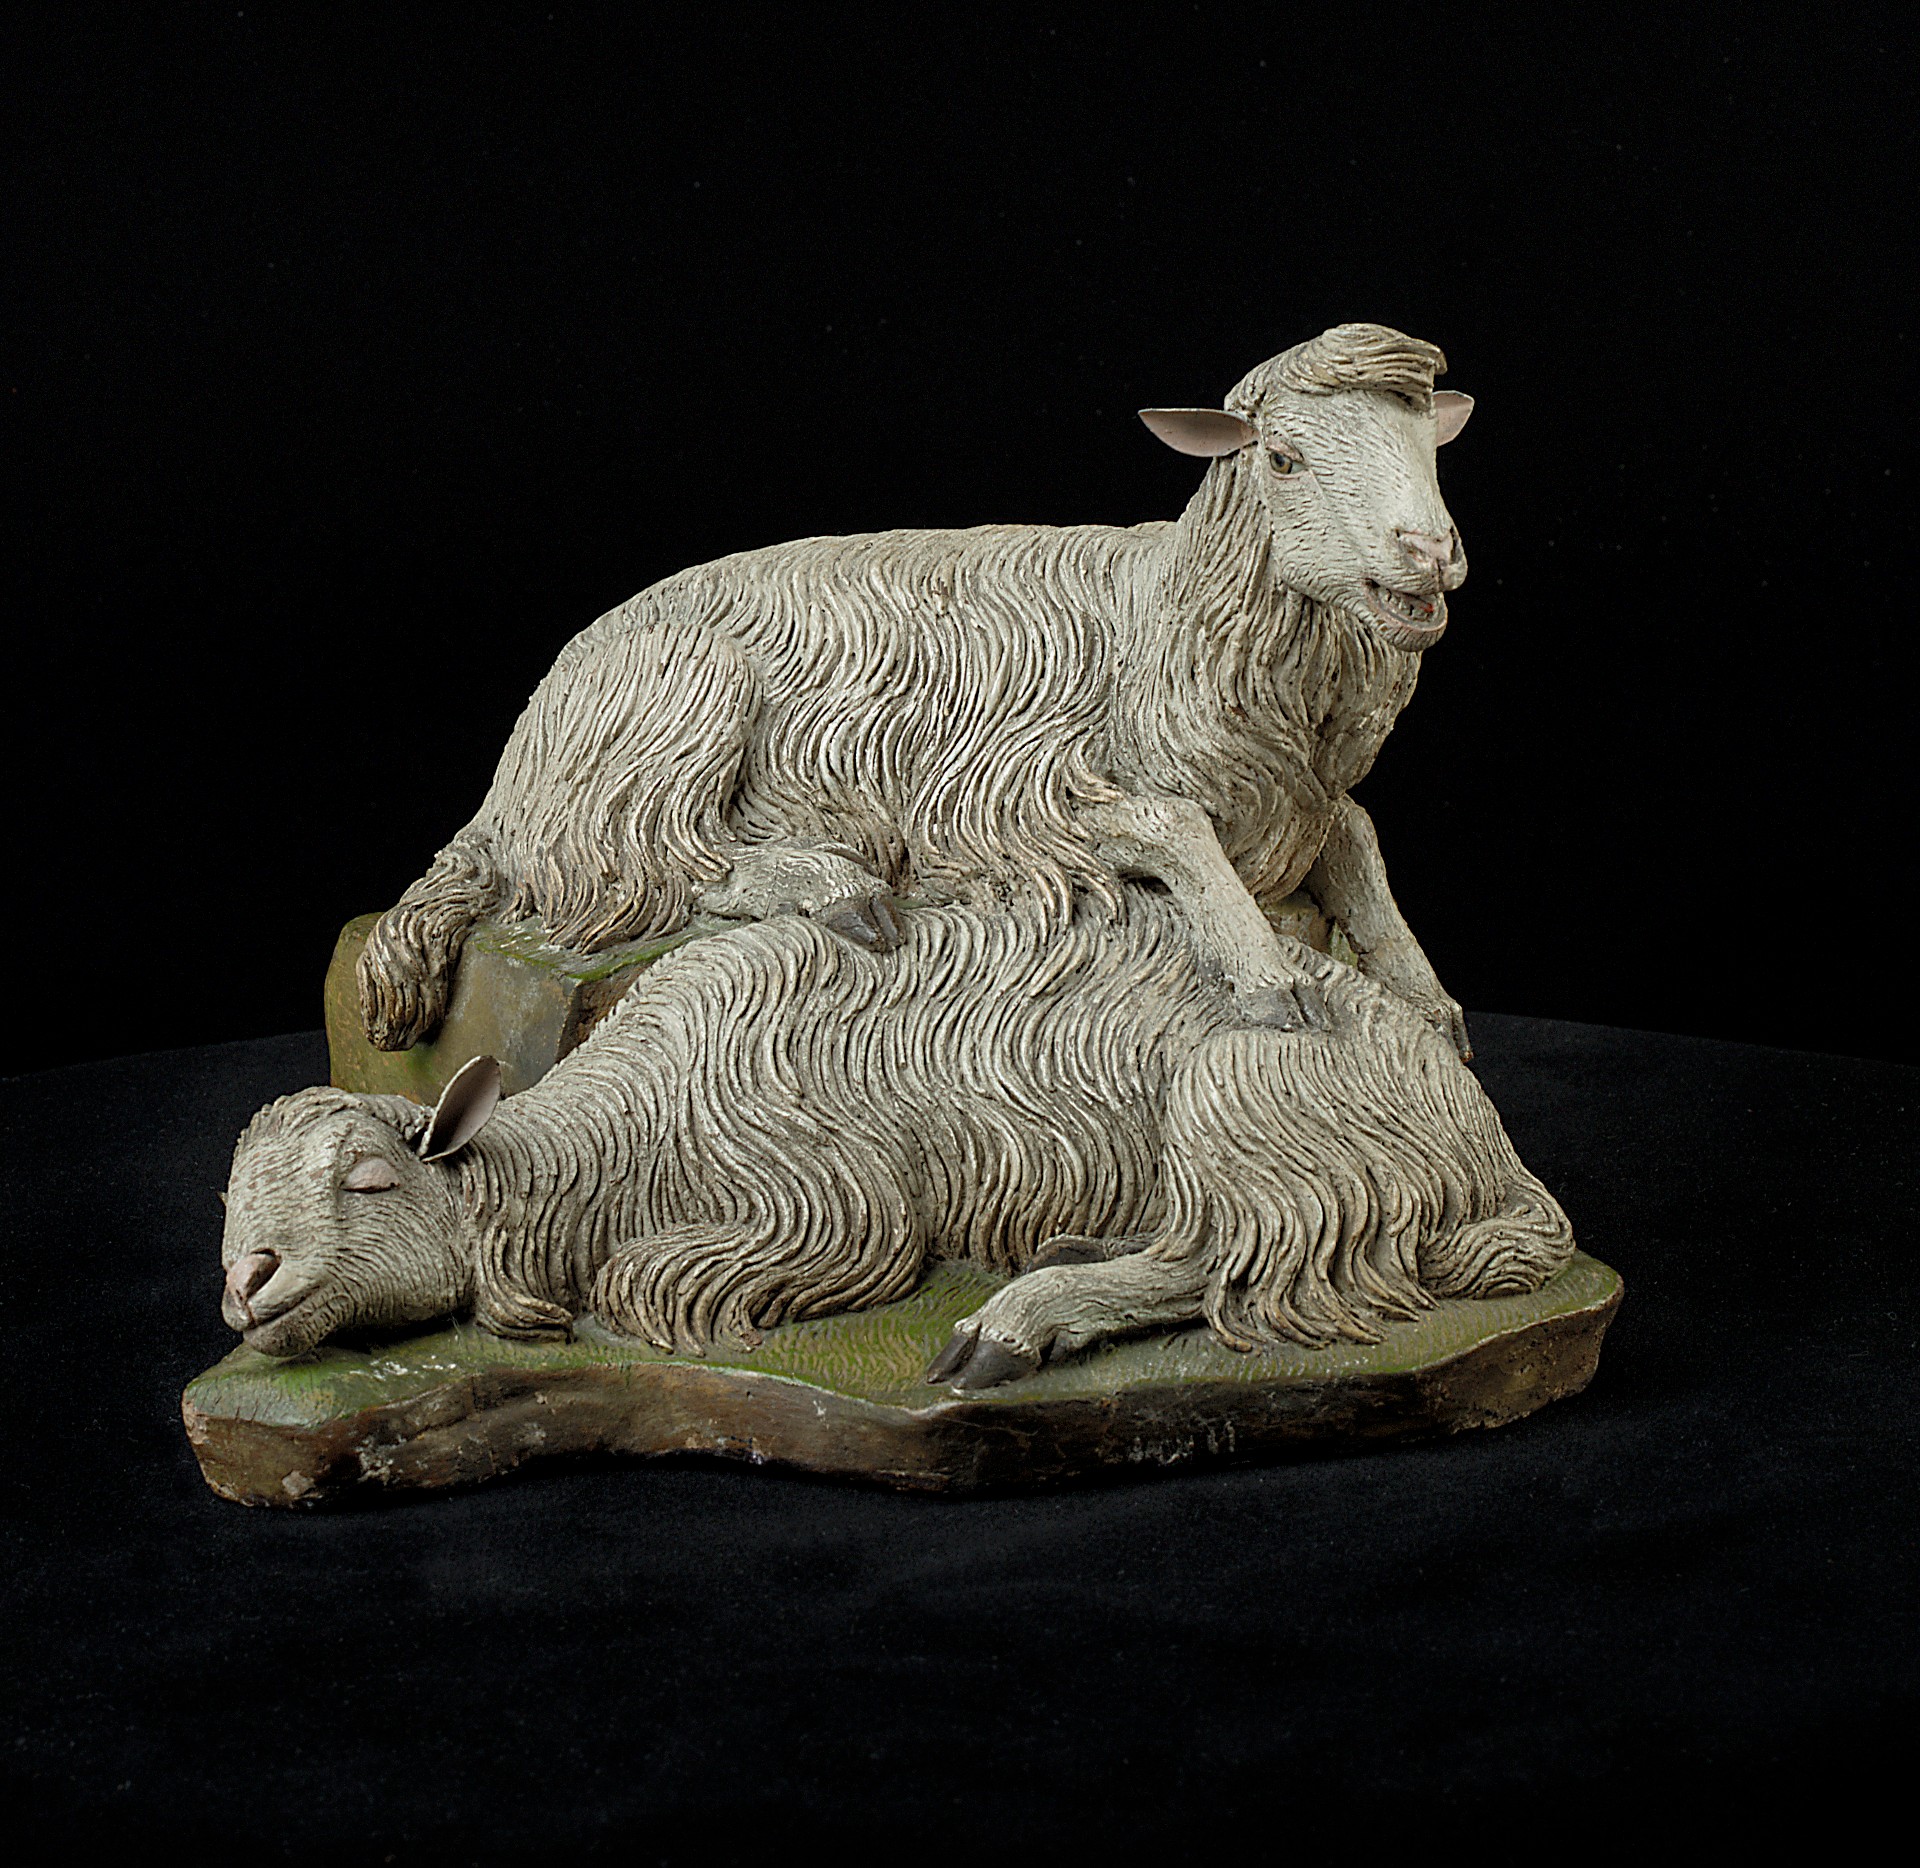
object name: crèche figure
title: Pair of sheep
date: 1701-1800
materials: terracotta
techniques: polychrome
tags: sheep